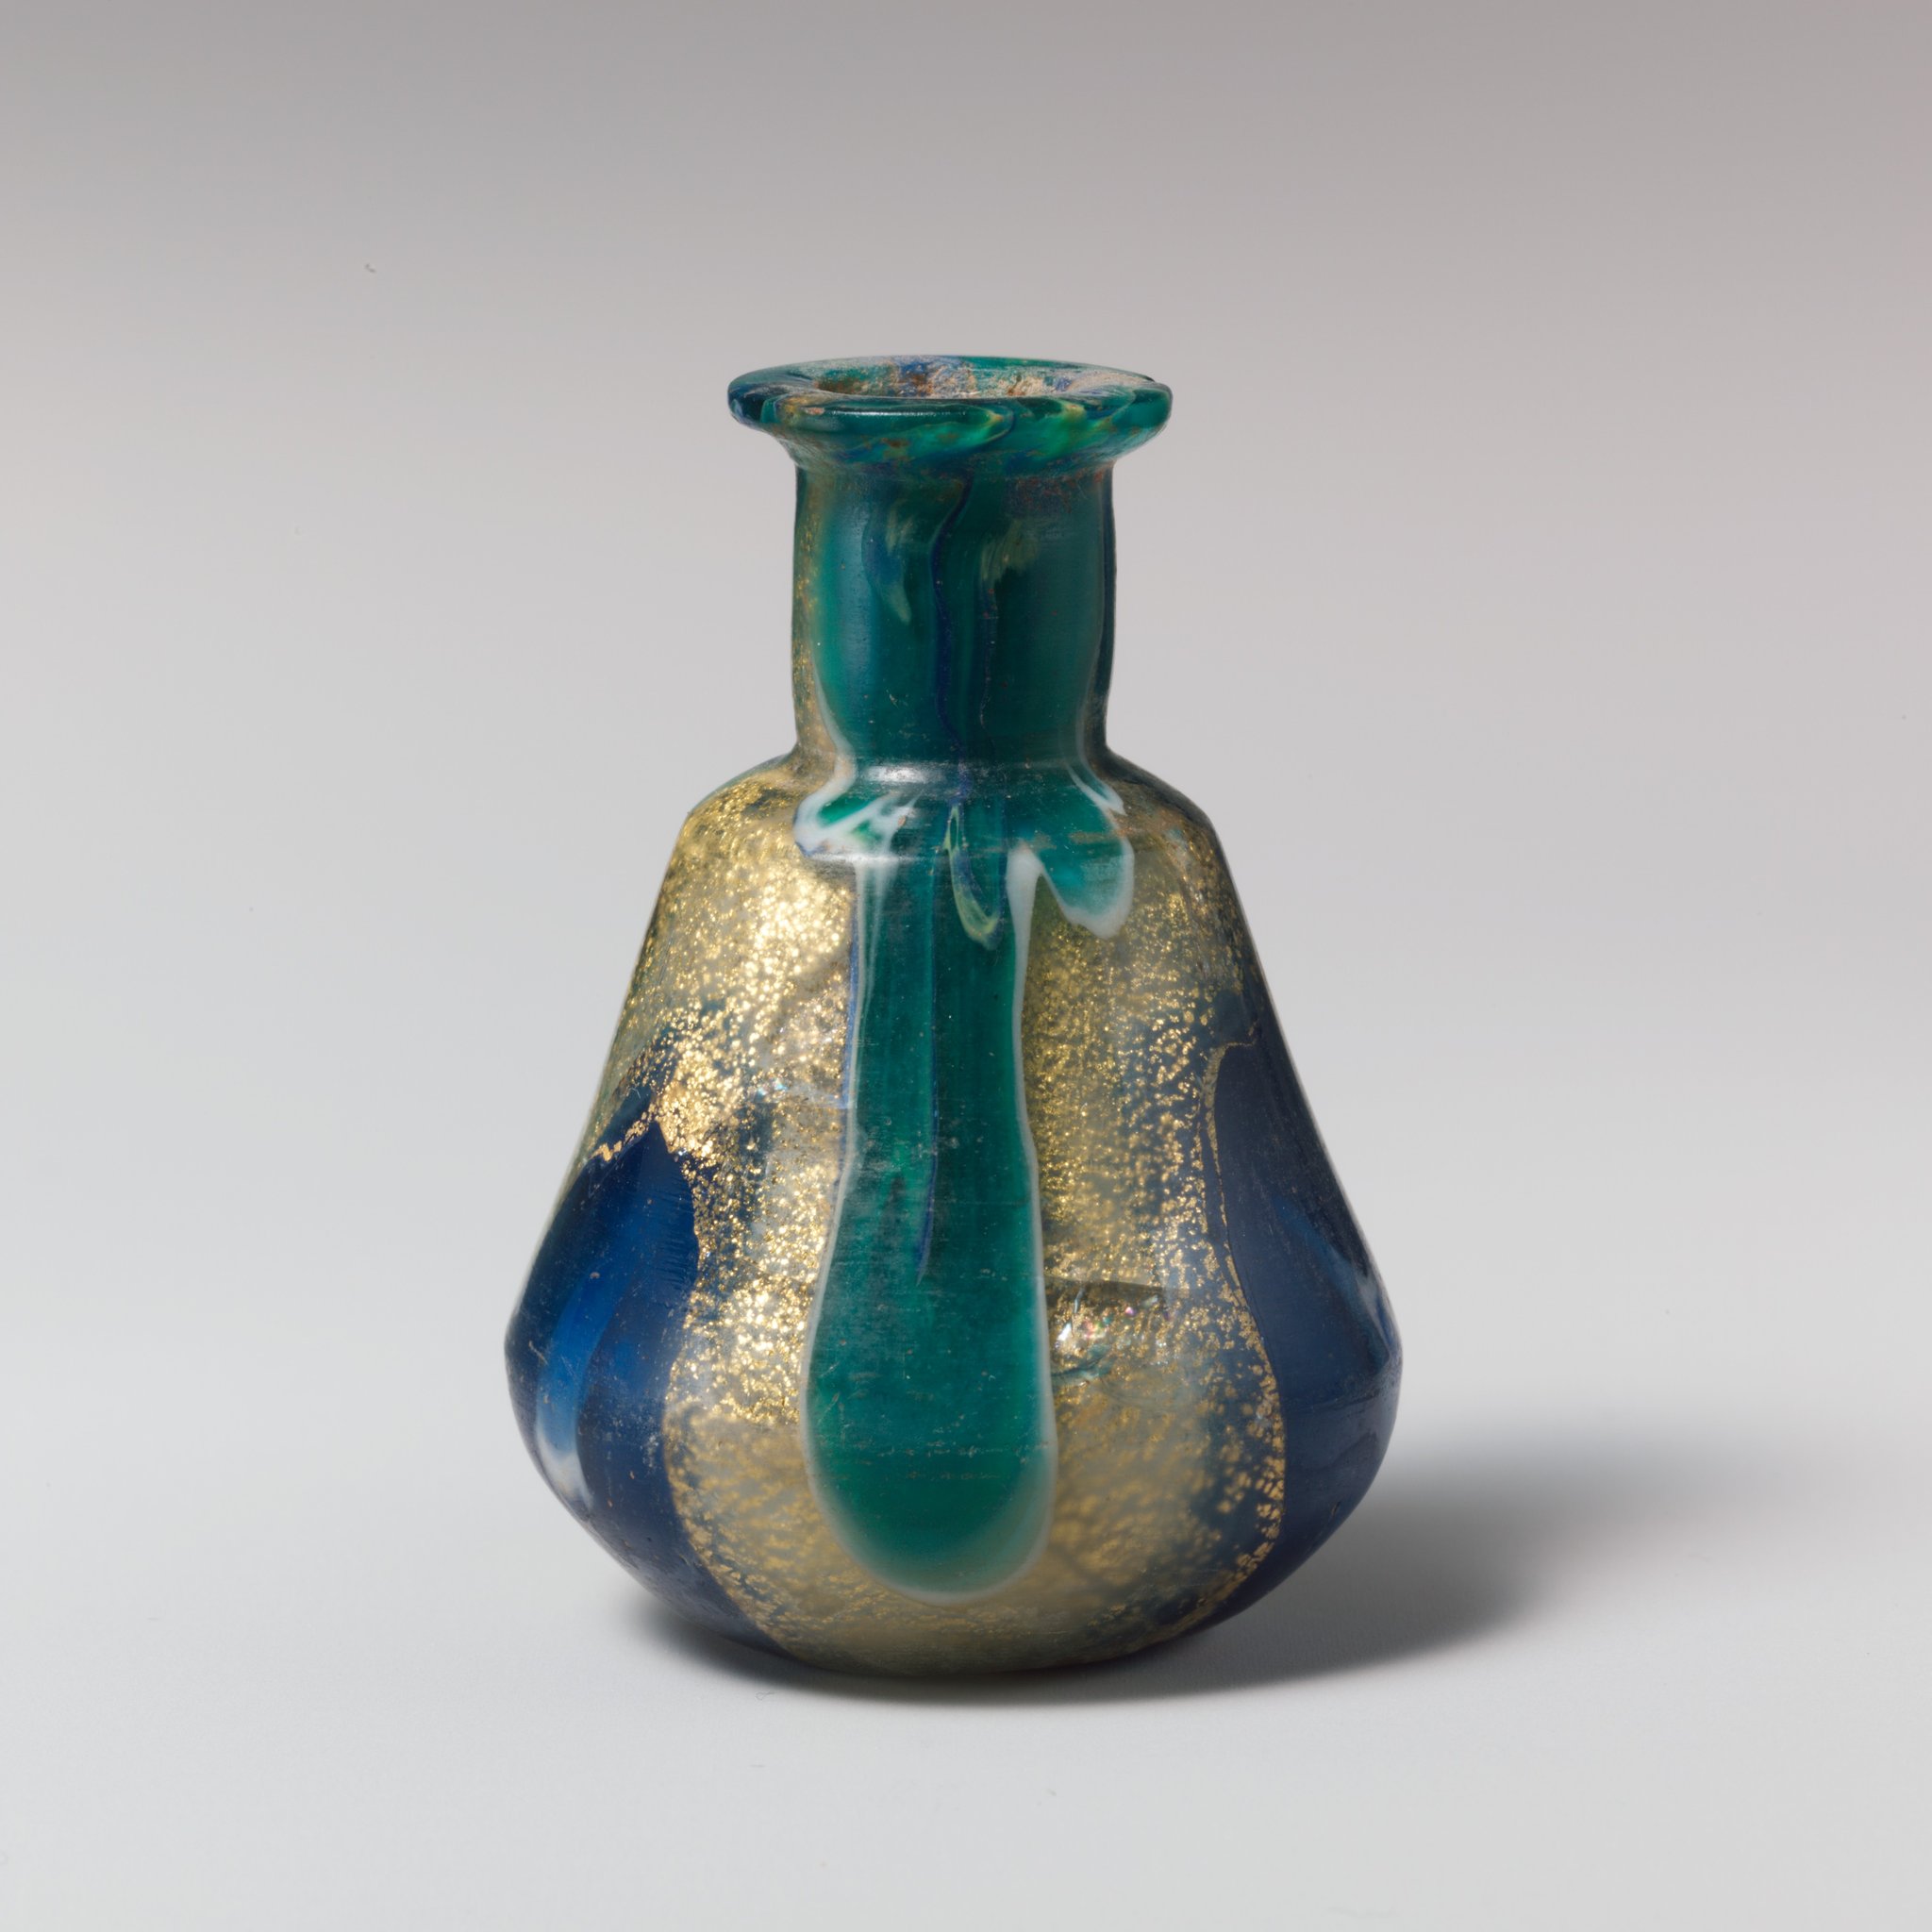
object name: bottle, gold band mosaic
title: Glass gold-band mosaic bottle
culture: roman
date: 1-50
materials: glass